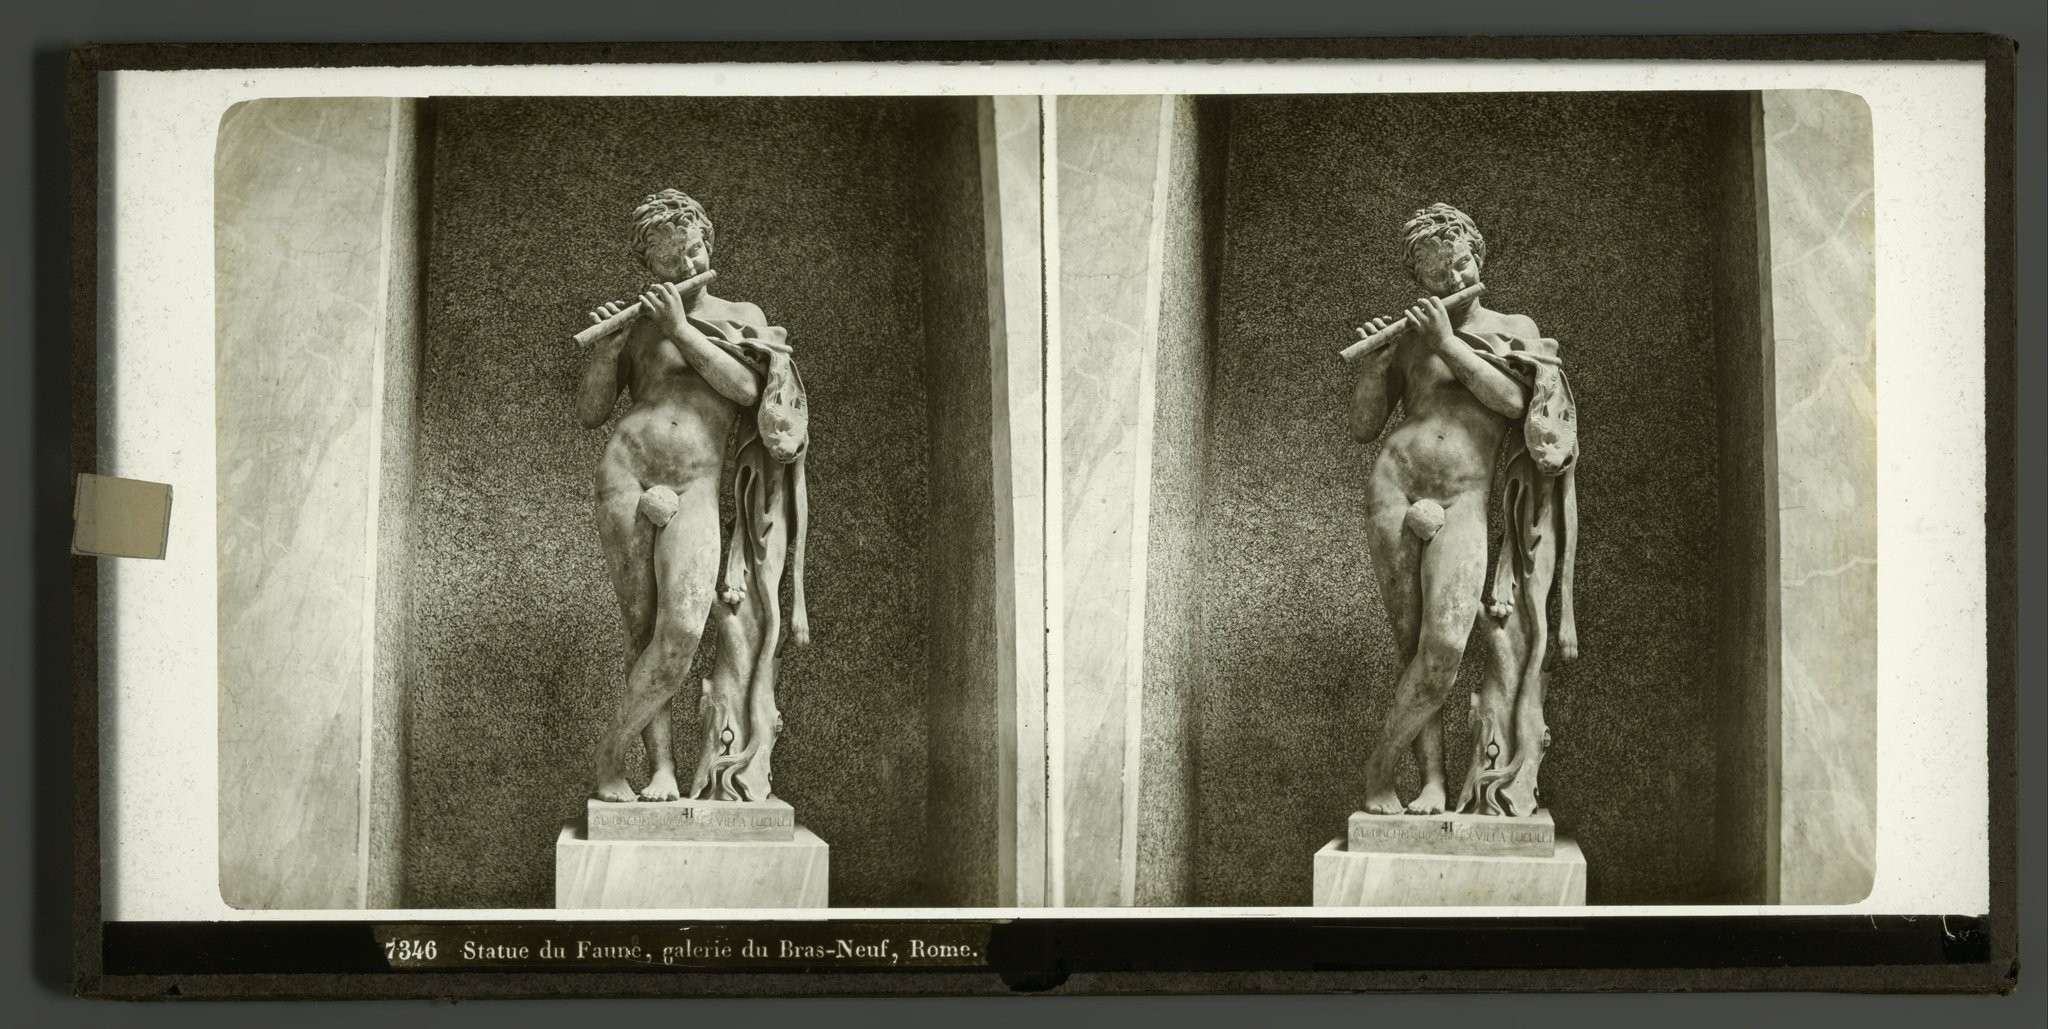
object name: stereoscopic photograph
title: Standbeeld van Faun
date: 1860-1870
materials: glass, paper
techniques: slide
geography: rome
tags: satyrs, fauns, sileni, sculpture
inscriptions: inscription: ‘7346 Statue de Faune, galerie du Bras-Neuf, Rome’